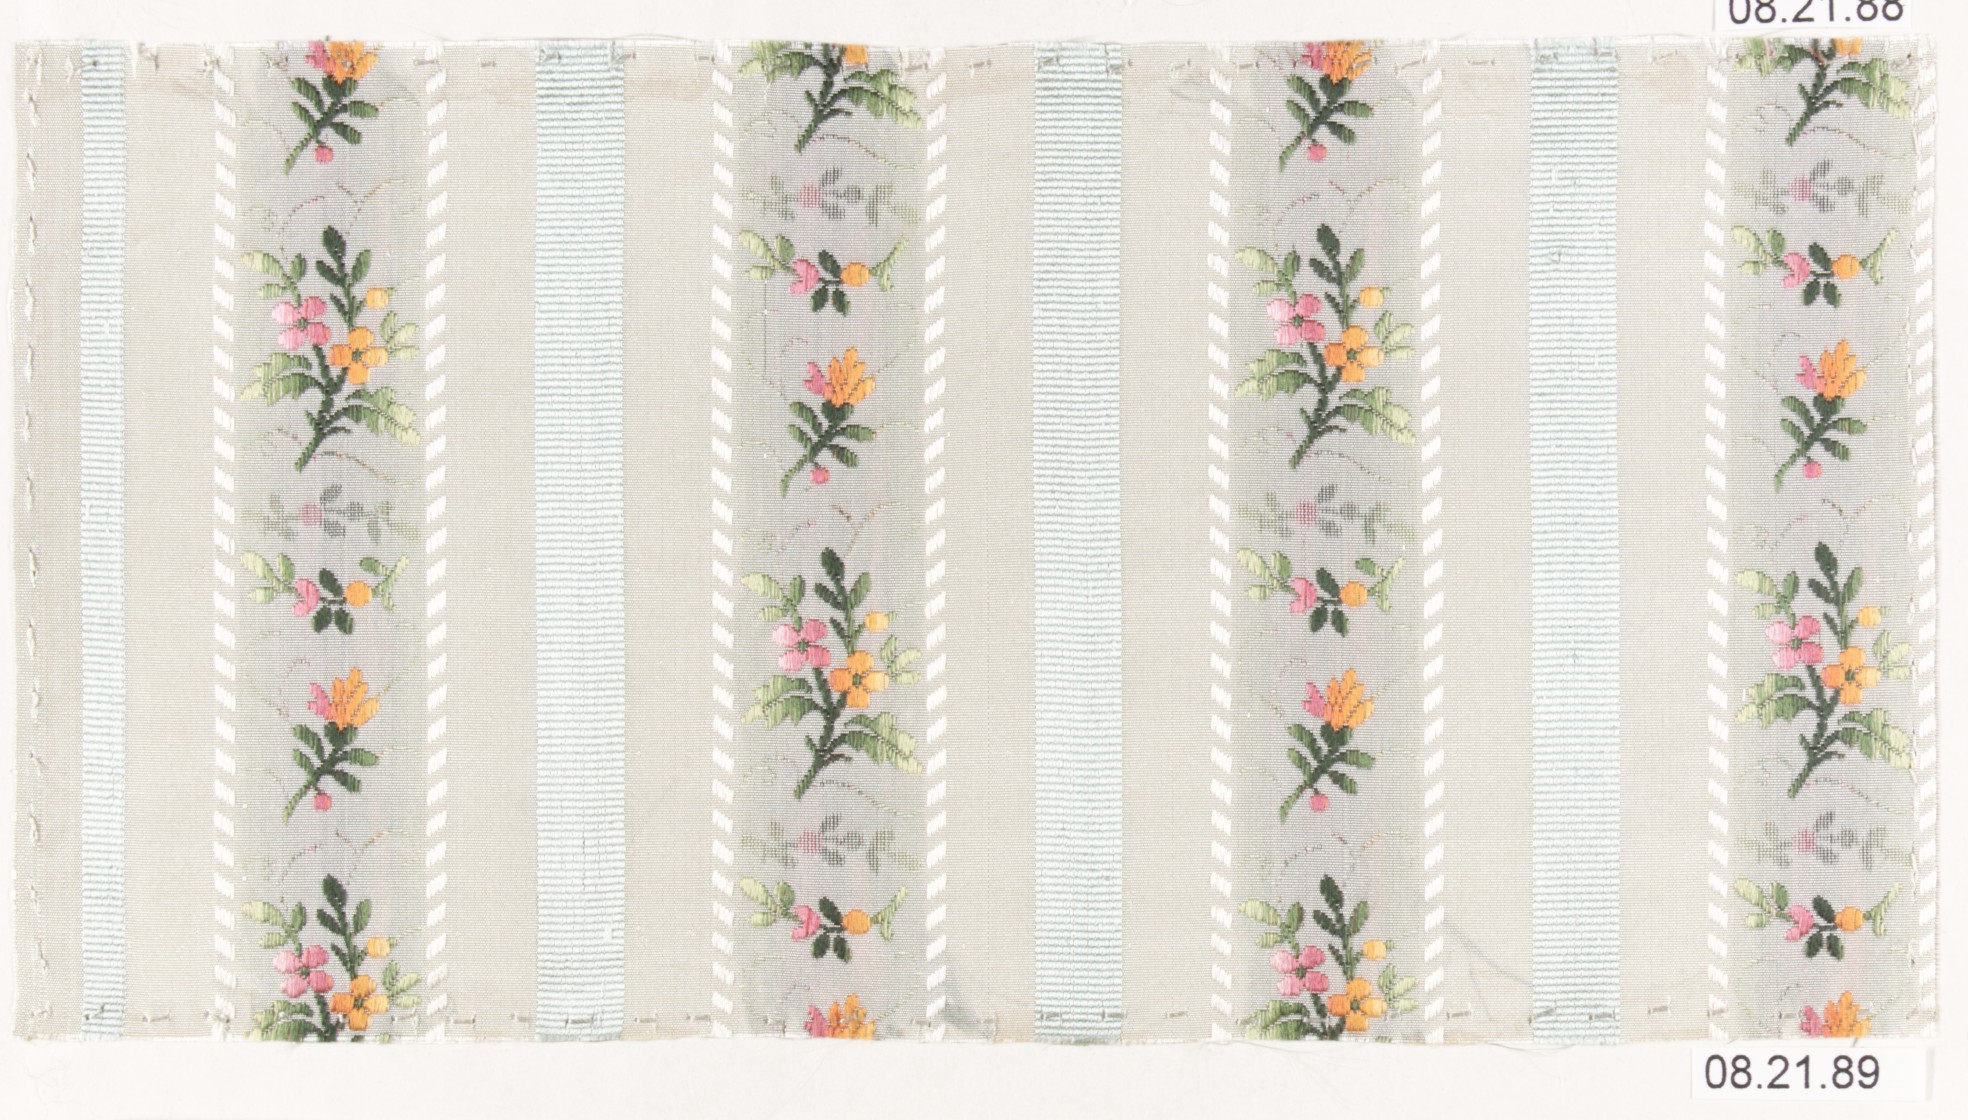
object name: textile sample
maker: Anonymous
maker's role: designer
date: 1900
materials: silk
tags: flowers